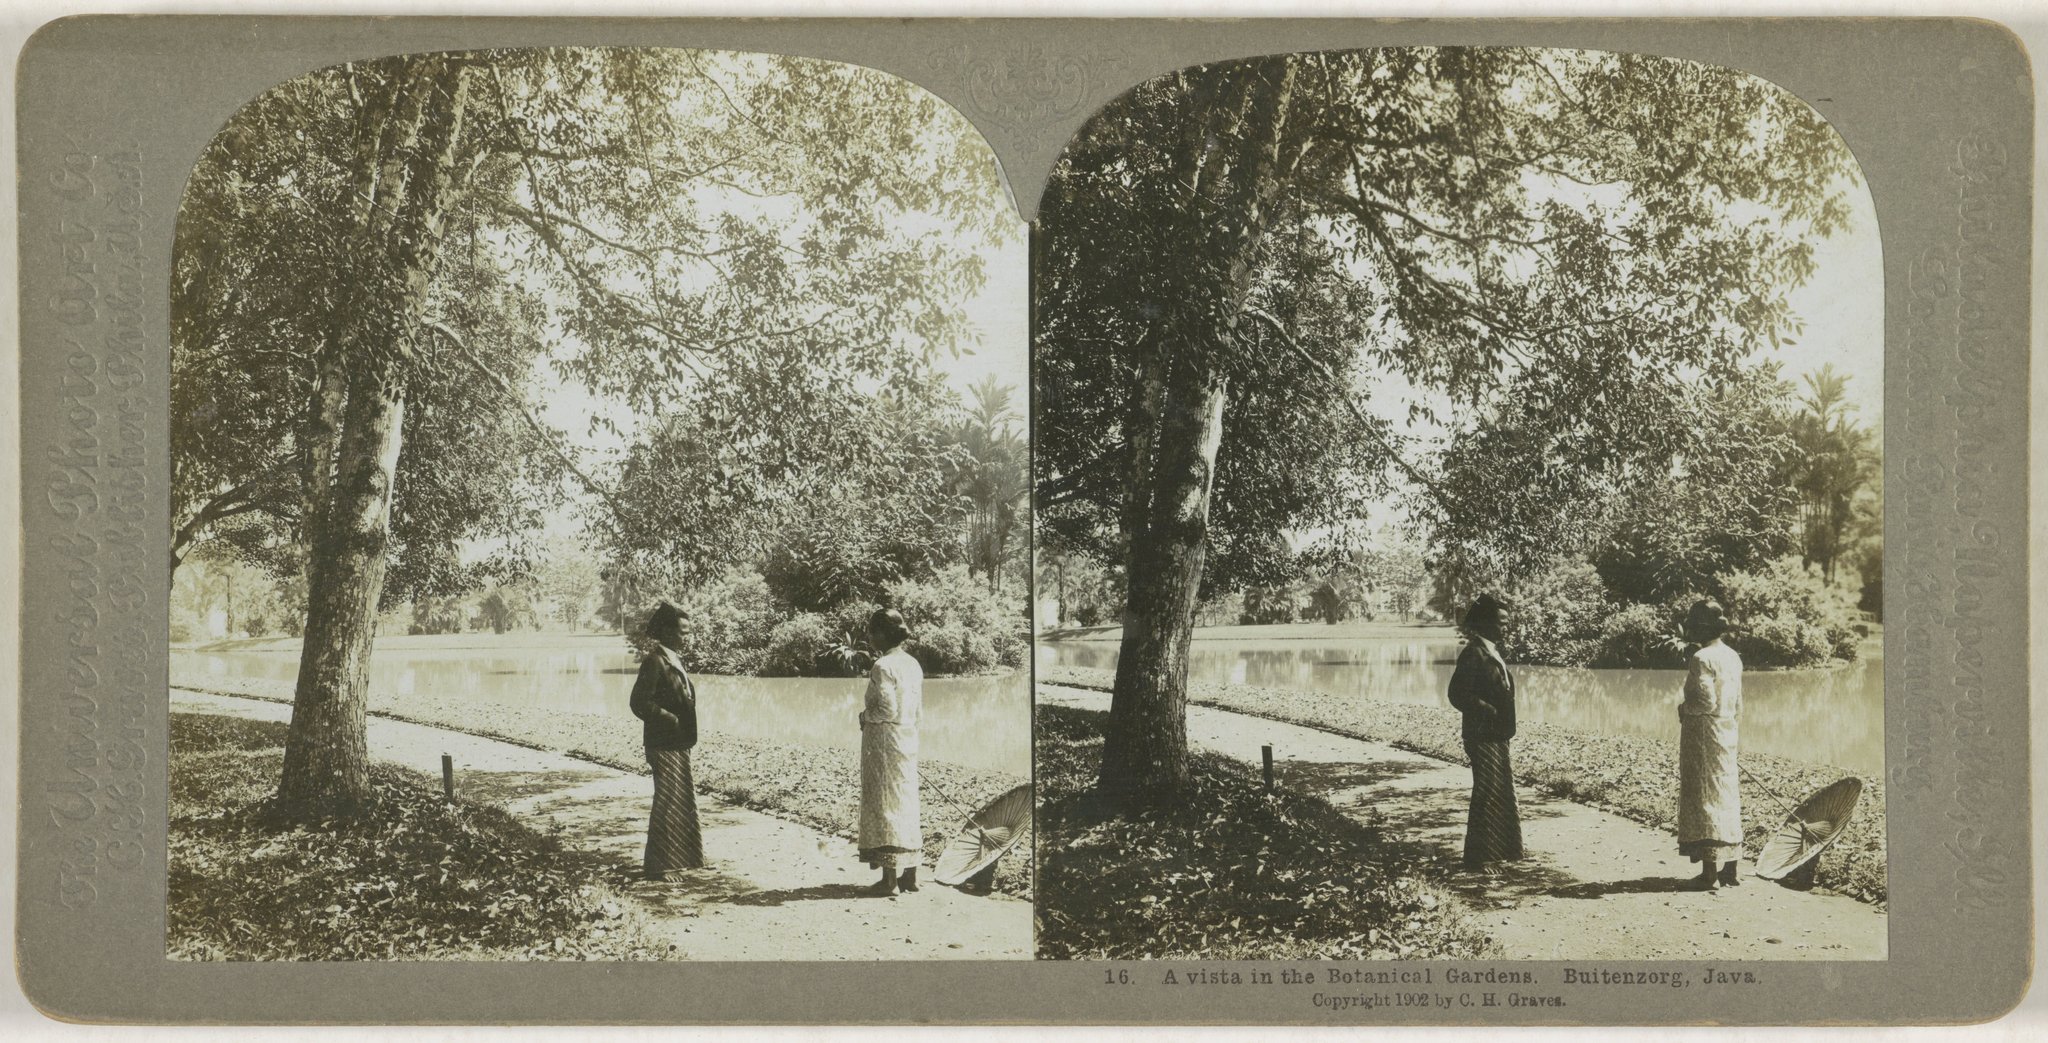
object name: stereograph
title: A vista in the Botanical Gardens. Buitenzorg, Java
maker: carleton harlow graves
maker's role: fotograaf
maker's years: 1867-1943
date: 1902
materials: paper, cardboard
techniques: gelatin silver print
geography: kebun raya bogor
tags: botanic garden, 'hortus botanicus'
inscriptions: number: ‘5’, copyright notice: ‘Copyright 1902 by C. H. Graves.’, number: ‘16.’